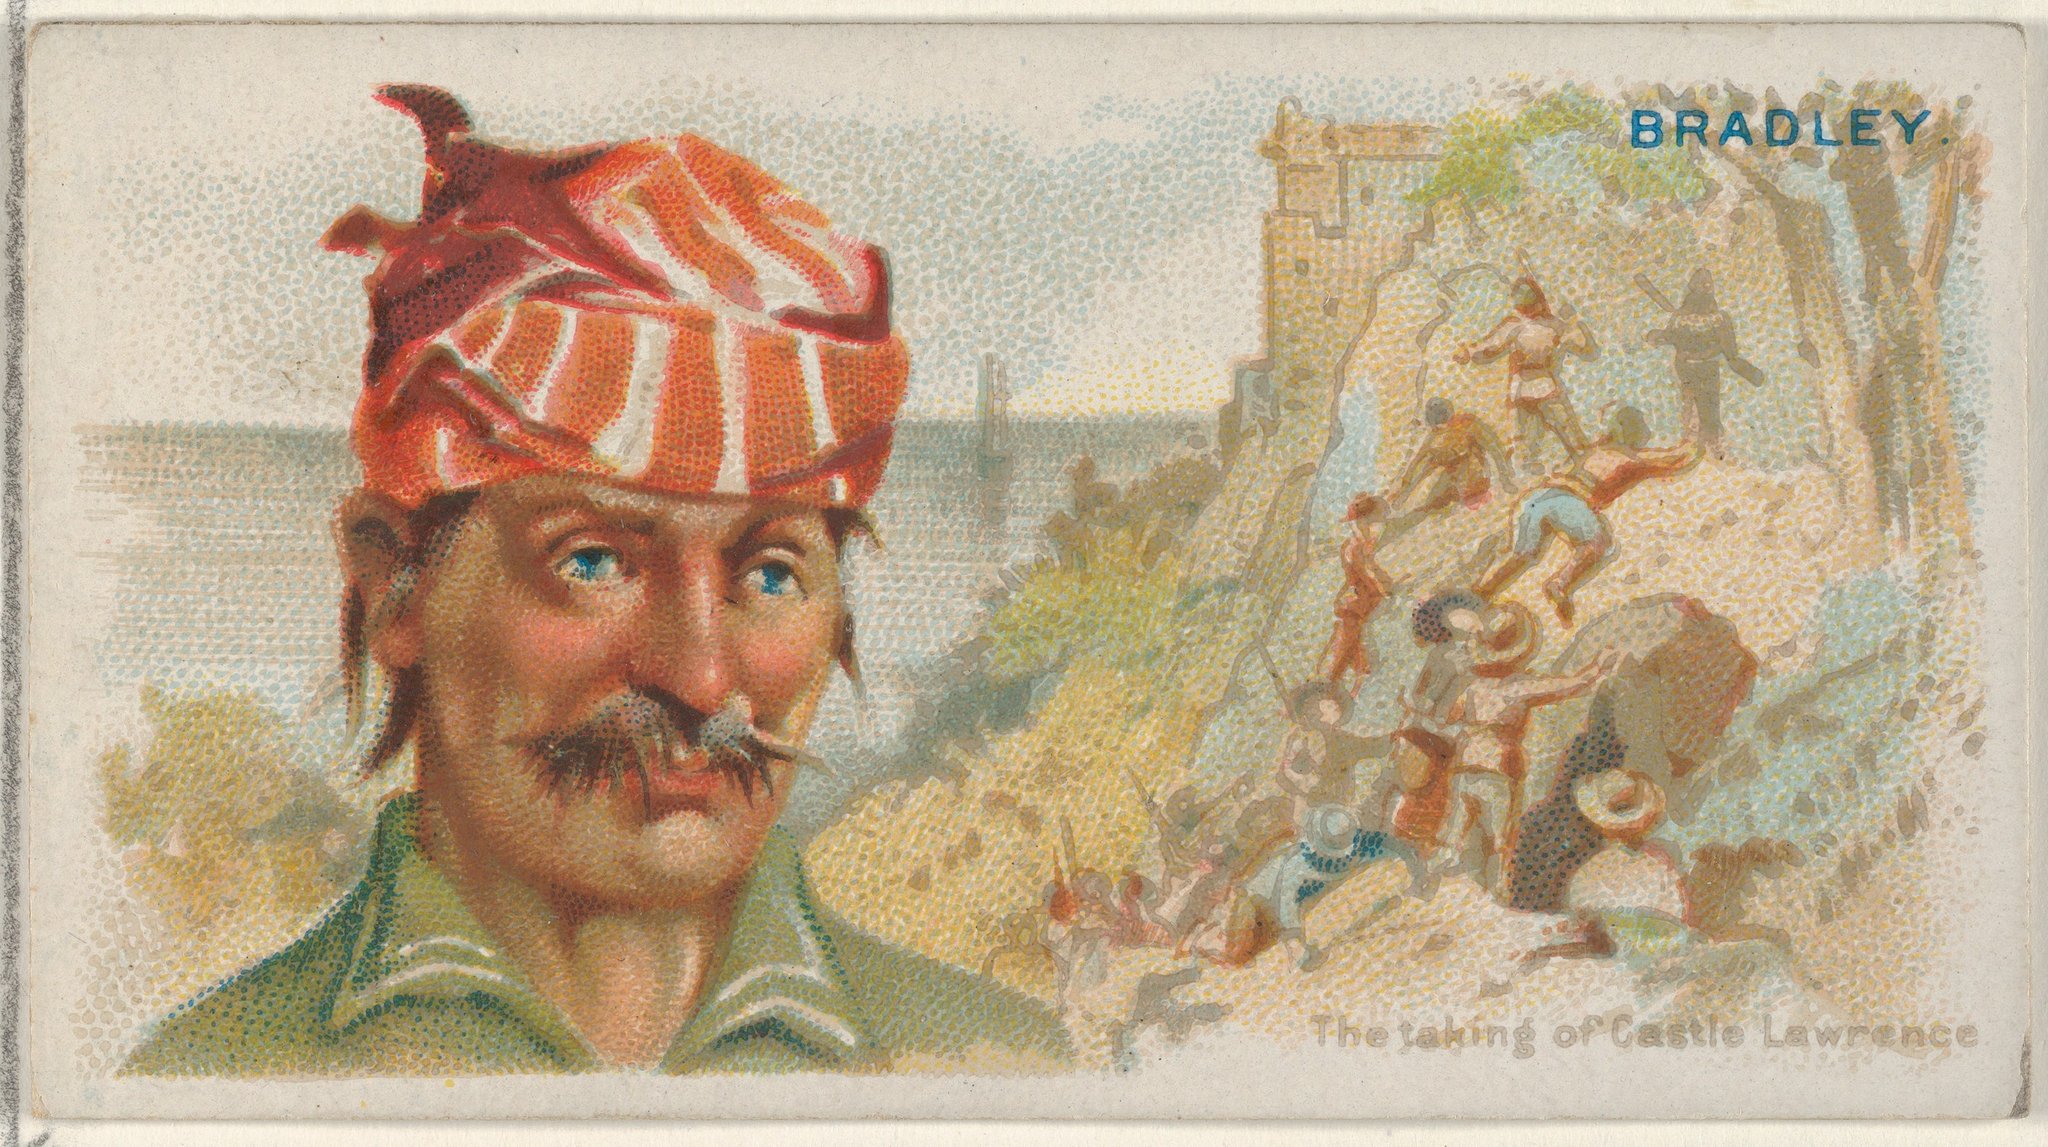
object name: print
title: Bradley, The Taking of Castle Lawrence, from the Pirates of the Spanish Main series (N19) for Allen & Ginter Cigarettes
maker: allen & ginter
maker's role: publisher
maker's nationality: american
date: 1888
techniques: color lithograph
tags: men